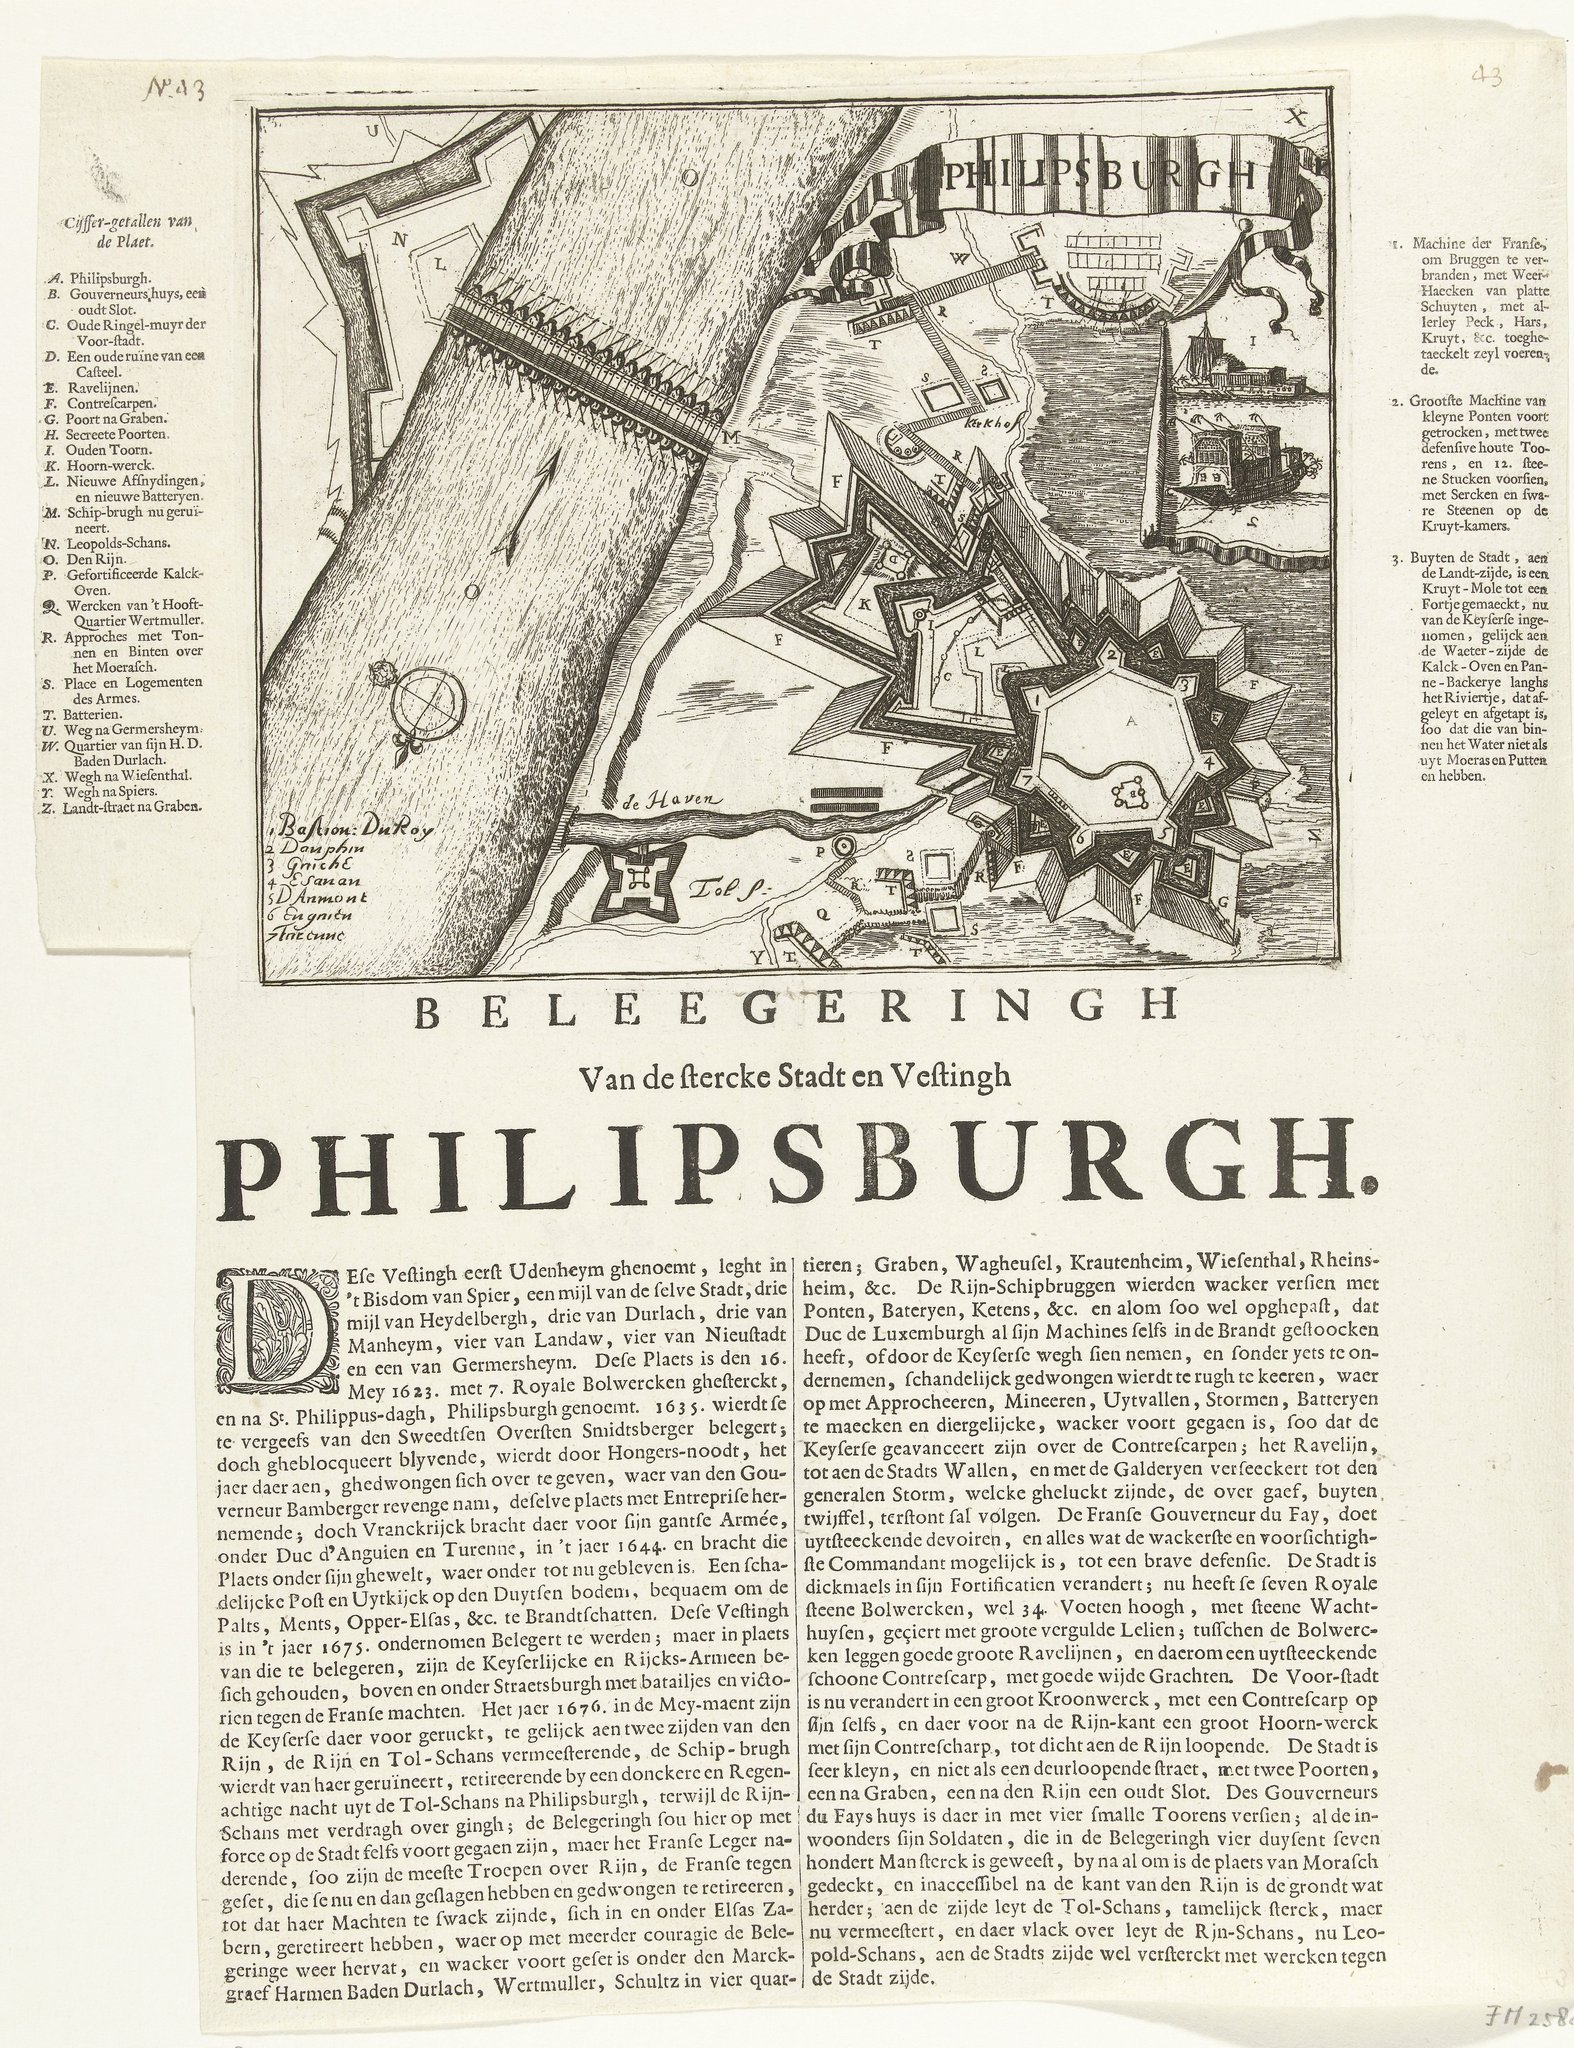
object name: print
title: Beleegeringh Van de stercke Stadt en Vestingh Philipsburgh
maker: Anonymous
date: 1676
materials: paper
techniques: etching, letterpress printing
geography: low countries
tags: leopold i (keizer van duitsland), siege, position war, maps of cities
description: Blad met een plattegrond en beschrijving van het beleg en de verovering van Philippsburg, in Franse handen, door de troepen van keizer Leopold I, mei-september 1676. Fortificaties en de schipbrug over de Rijn. In de plaat de legenda 1-7. Aan weerszijden van de plaat de gedrukte legenda's A-Z en 1-3.